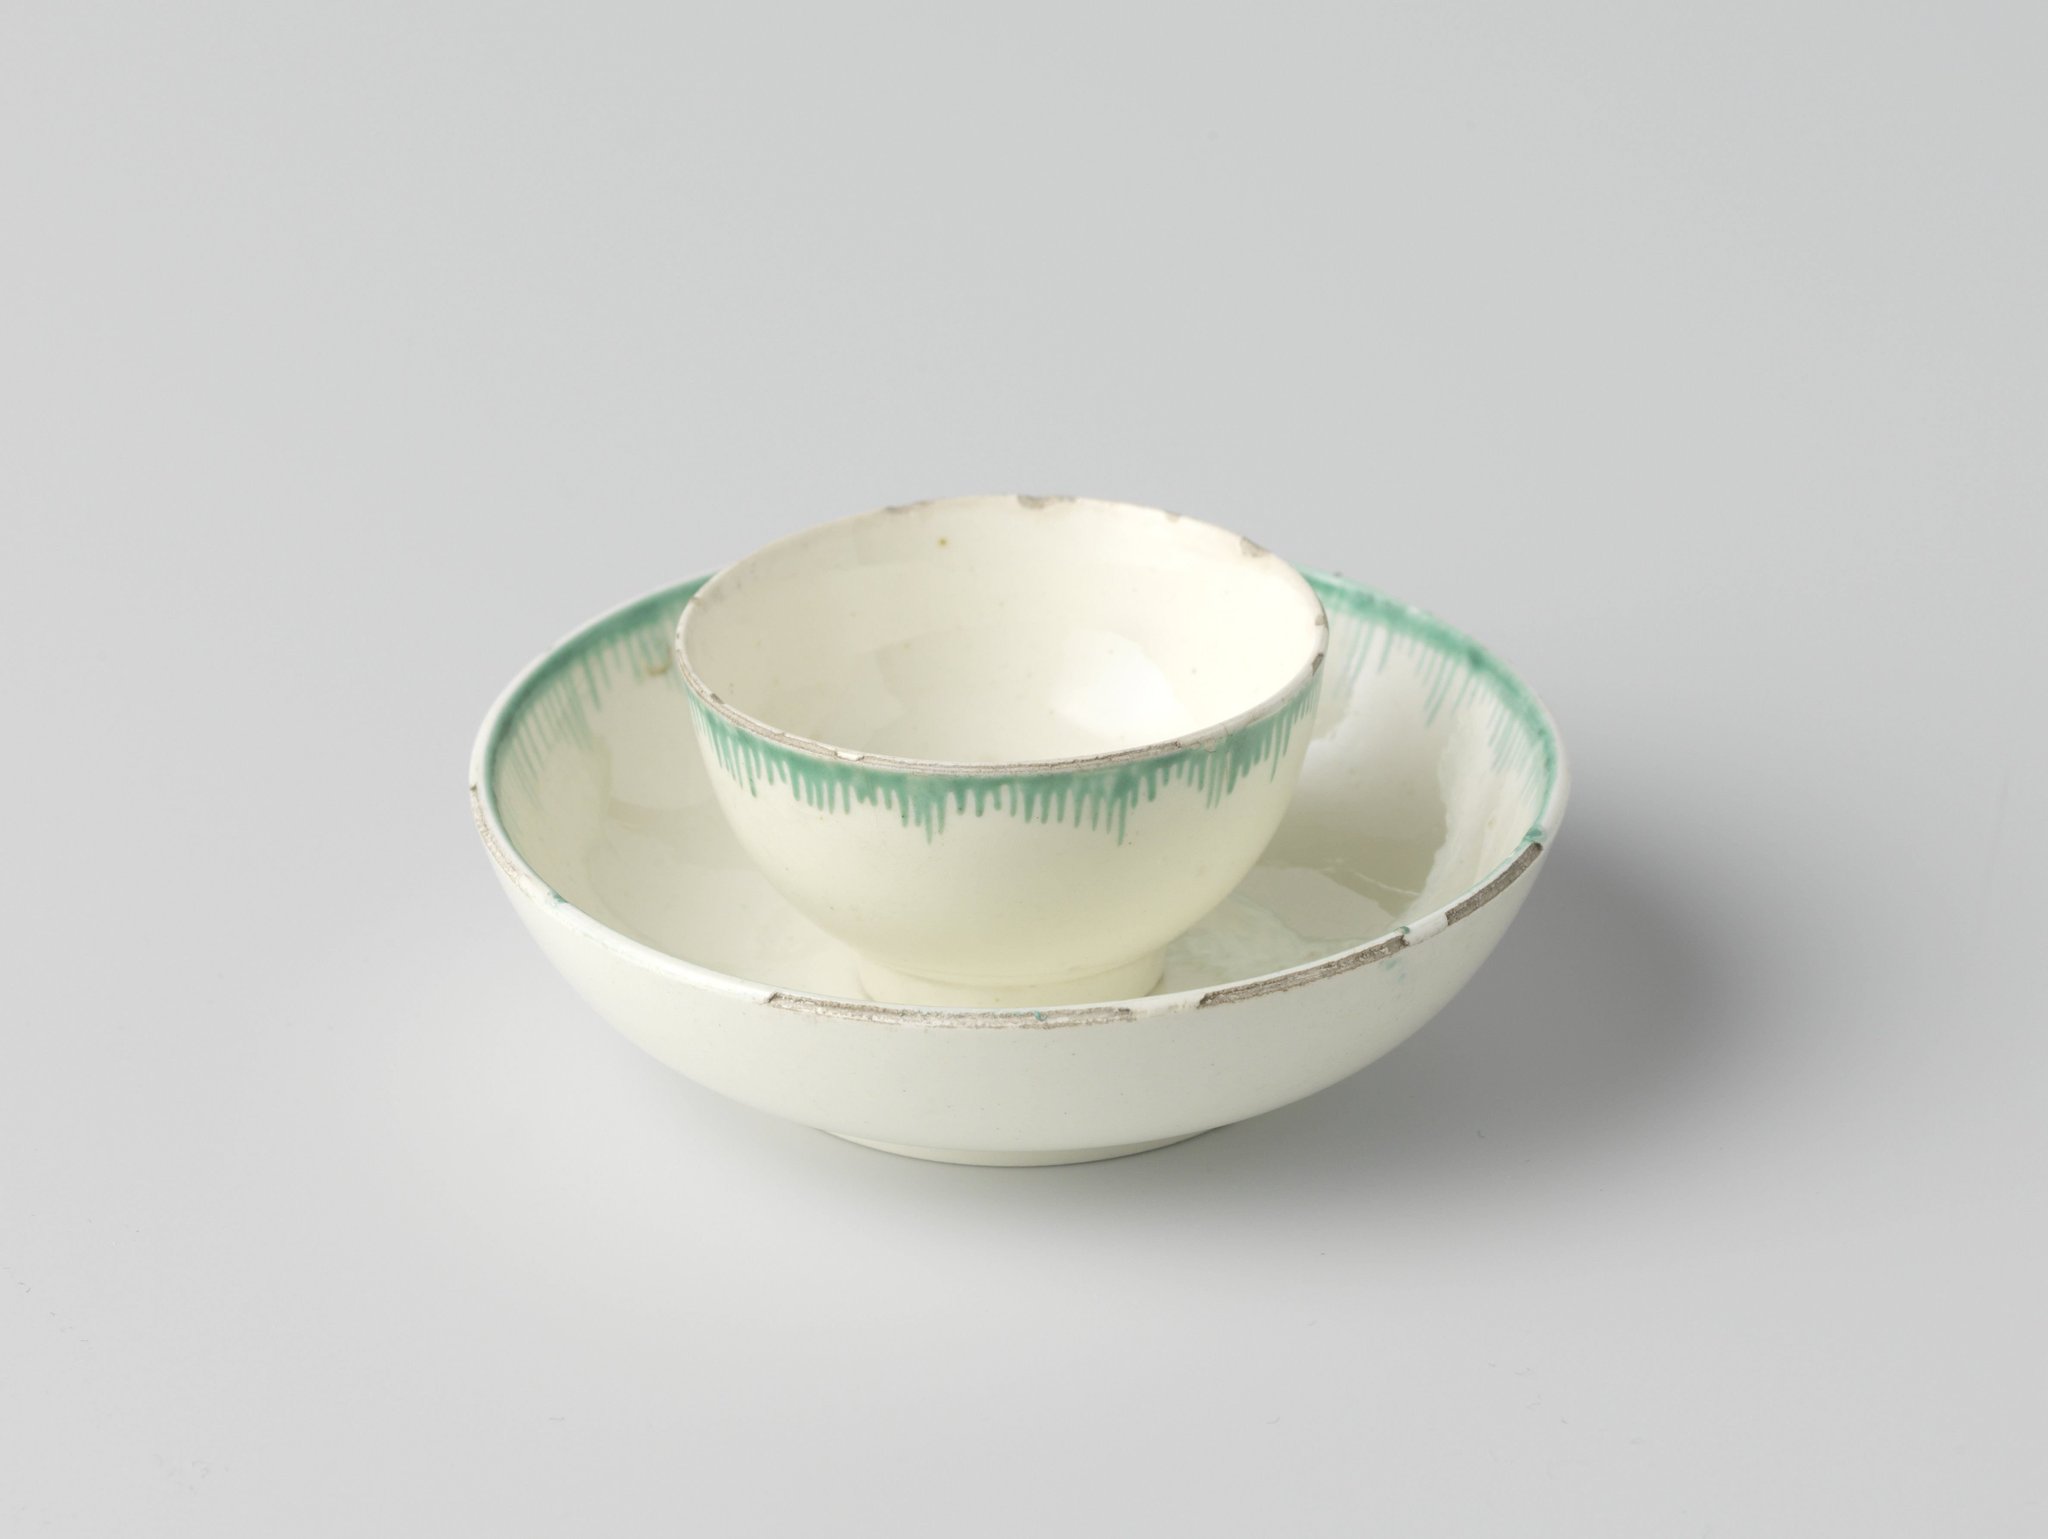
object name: kop en schotel, kop en schotel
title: Kop en schotel van hardgebakken aardewerk, creamware.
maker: Anonymous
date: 1790-1810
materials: earthenware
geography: england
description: Kop en schotel van hardgebakken aardewerk, van een kinderservies. Kop en schotel hebben beide een groene uitstralende rand. De kop en schotel horen bij drie kop en schotels (BK-NM-11012-A t/m BK-NM-11012-D. Bij de koppen en schotels hoort een theebus met invnr. BK-NM-11013.